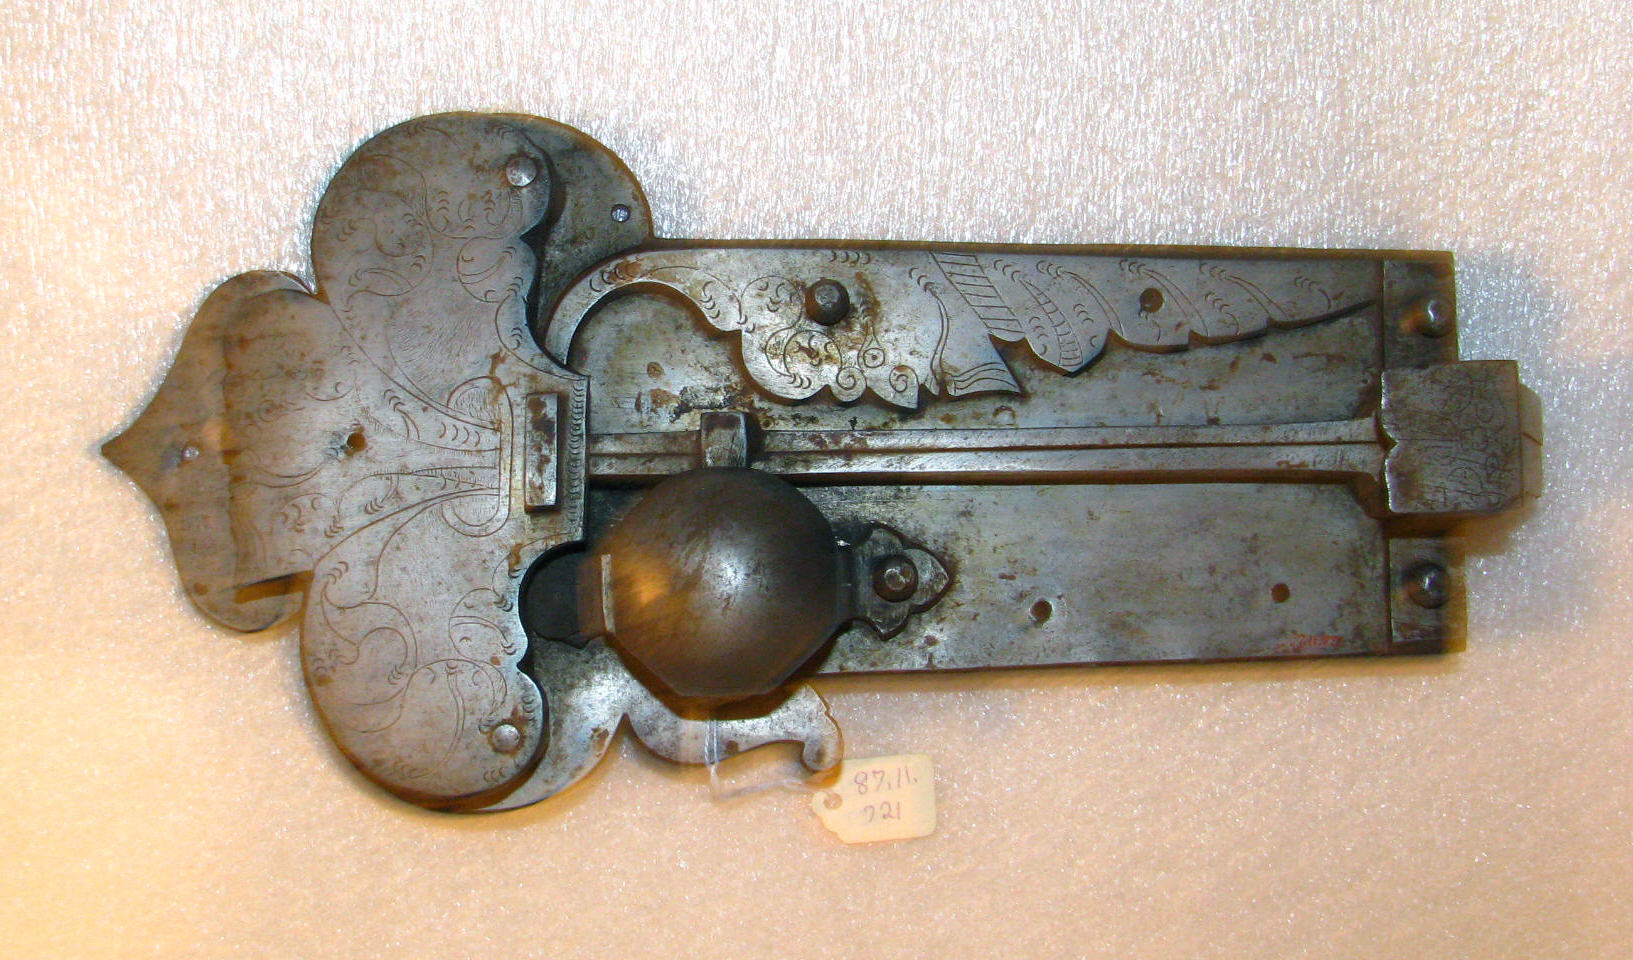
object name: rim lock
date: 1580-1640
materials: iron